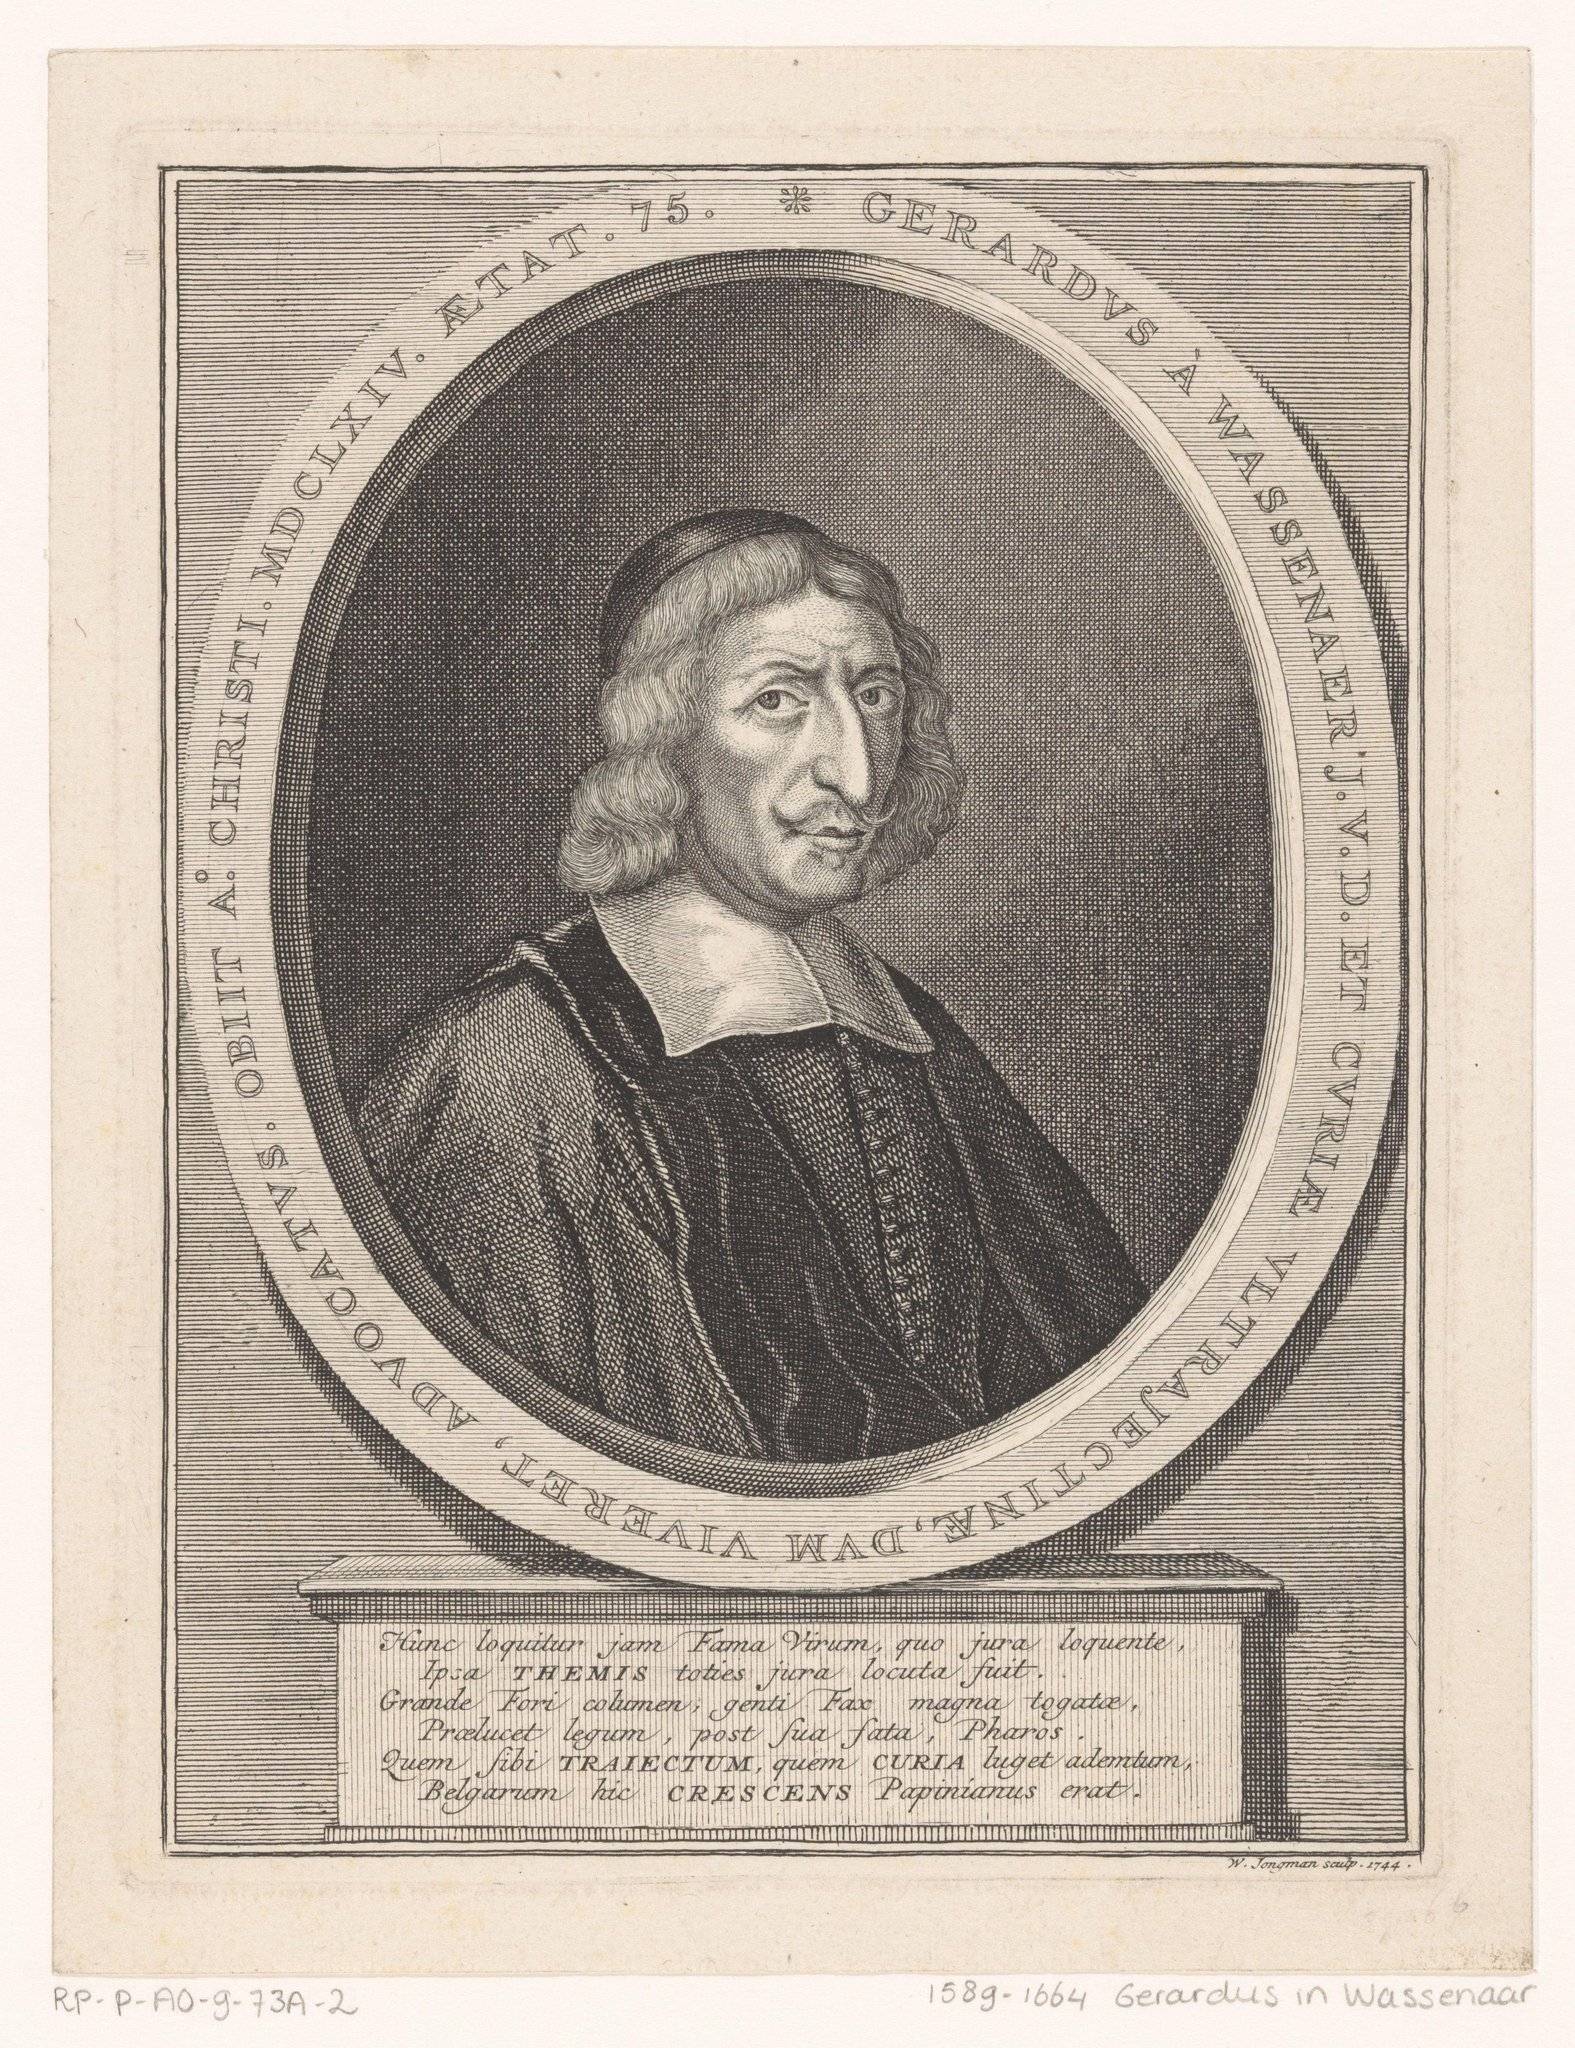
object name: print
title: Portret van Gerard van Wassenaer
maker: wouter jongman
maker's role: print maker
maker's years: -1753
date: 1744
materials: paper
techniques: engraving, etching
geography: amsterdam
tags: historical persons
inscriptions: date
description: Busteportret van de advocaat Gerard van Wassenaer, met bef en kalot. Het portret is gevat in een ovale omlijsting met een randschrift in het Latijn. Op de piëdestal een zesregelig onderschrift in het Latijn.